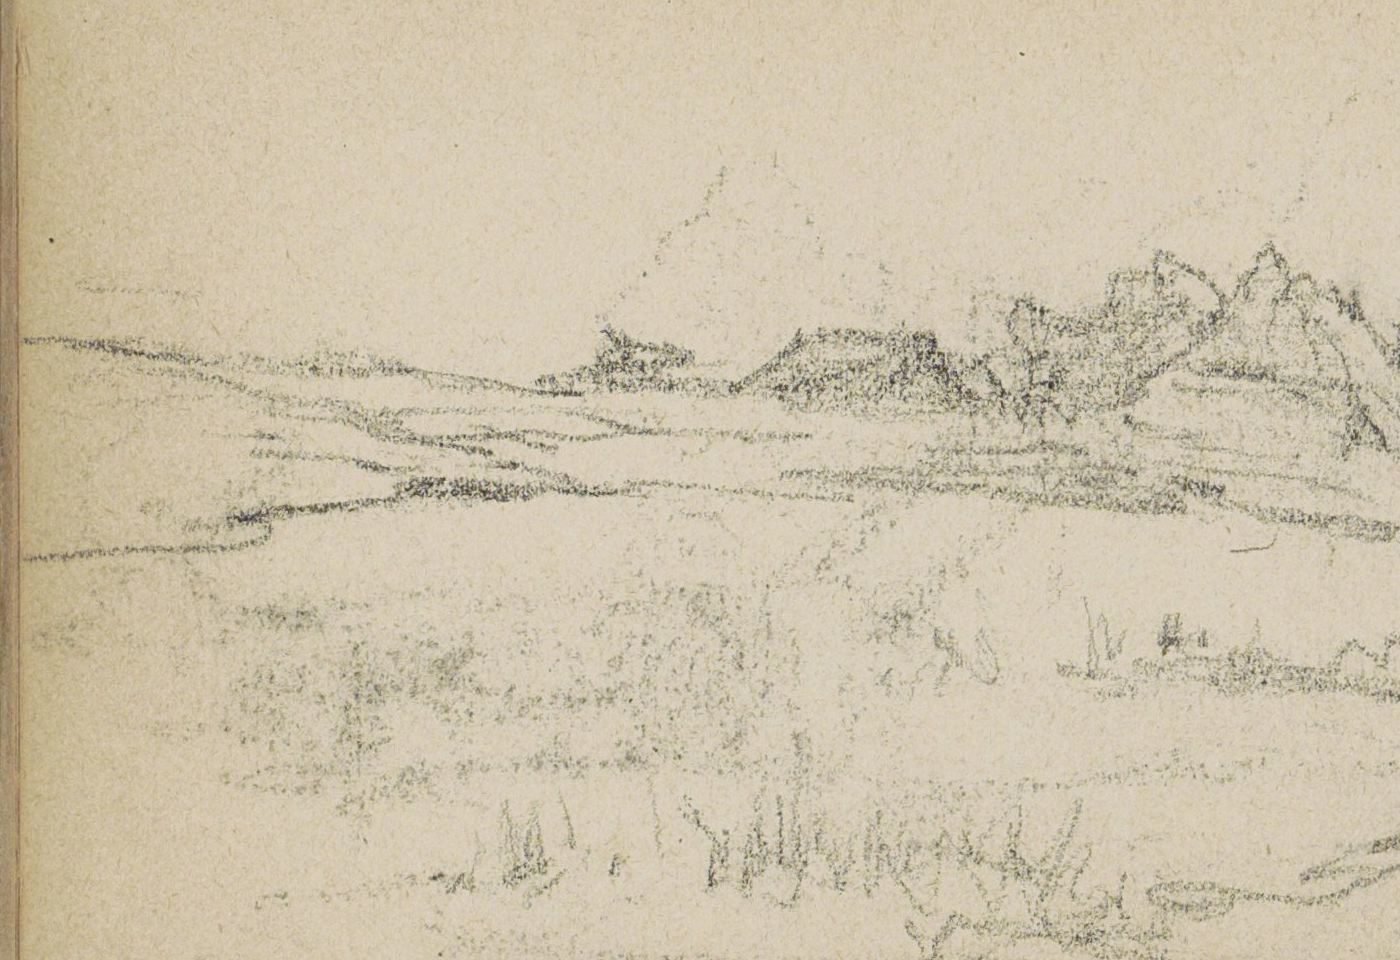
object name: sketchbook leaf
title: Waterplas De Clarinet bij Deurne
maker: willem cornelis rip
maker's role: draughtsman, painter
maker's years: 1856-1922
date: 1807-1897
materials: chalk, paper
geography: deurne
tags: landscapes with waters, waterscapes, seascapes (in the temperate zone)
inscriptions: date and inscription: ‘De Clarinet/ 29 juli 97.’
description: Blad 7 verso uit een schetsboek met 44 bladen.